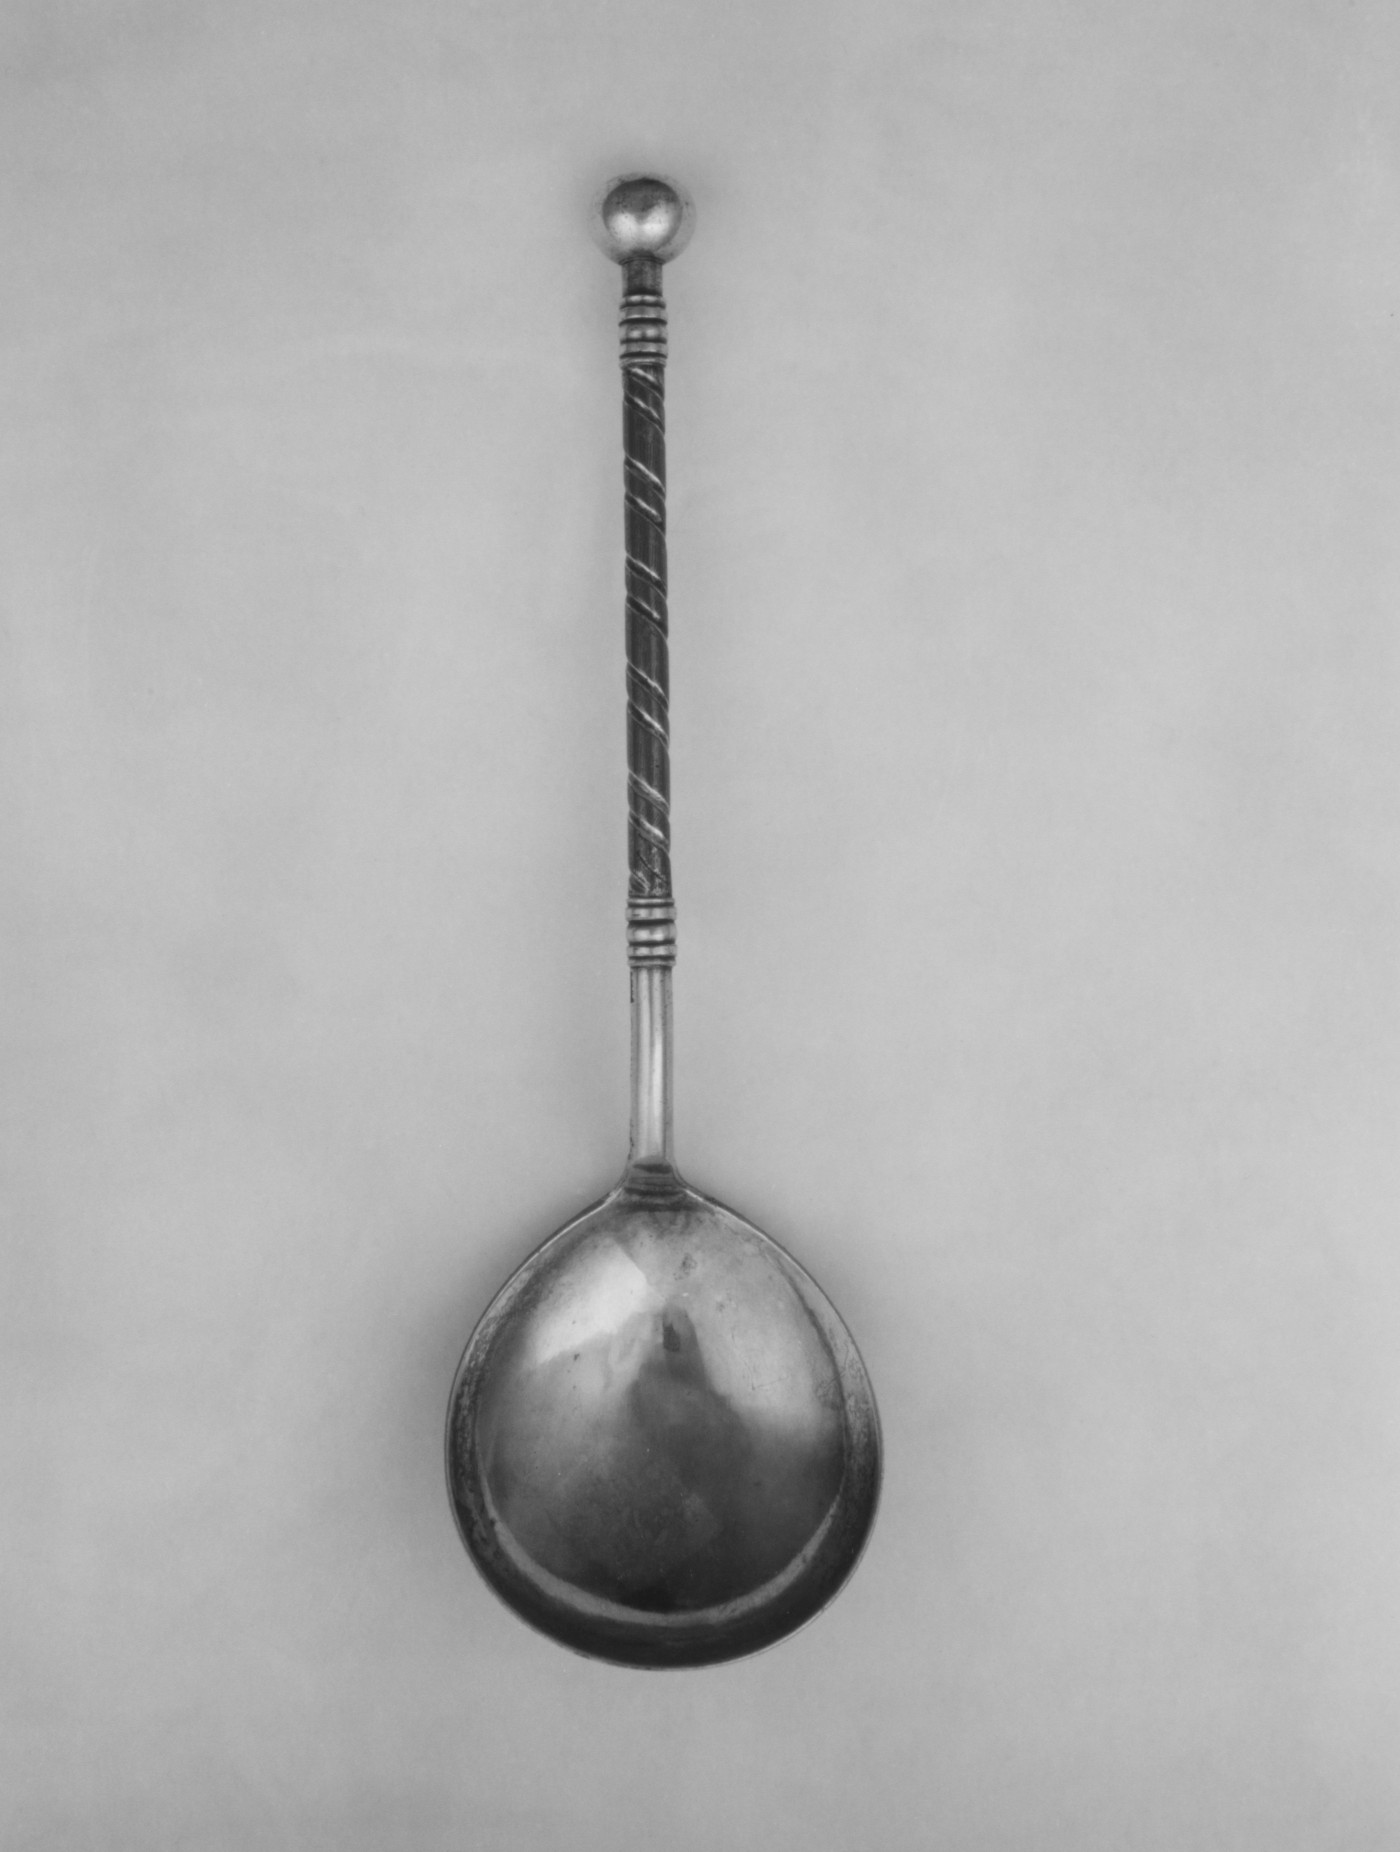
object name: spoon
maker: mikhail chulkov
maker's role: maker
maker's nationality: russian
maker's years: 1801-1864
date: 1839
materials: niello, silver gilt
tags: buildings,boats